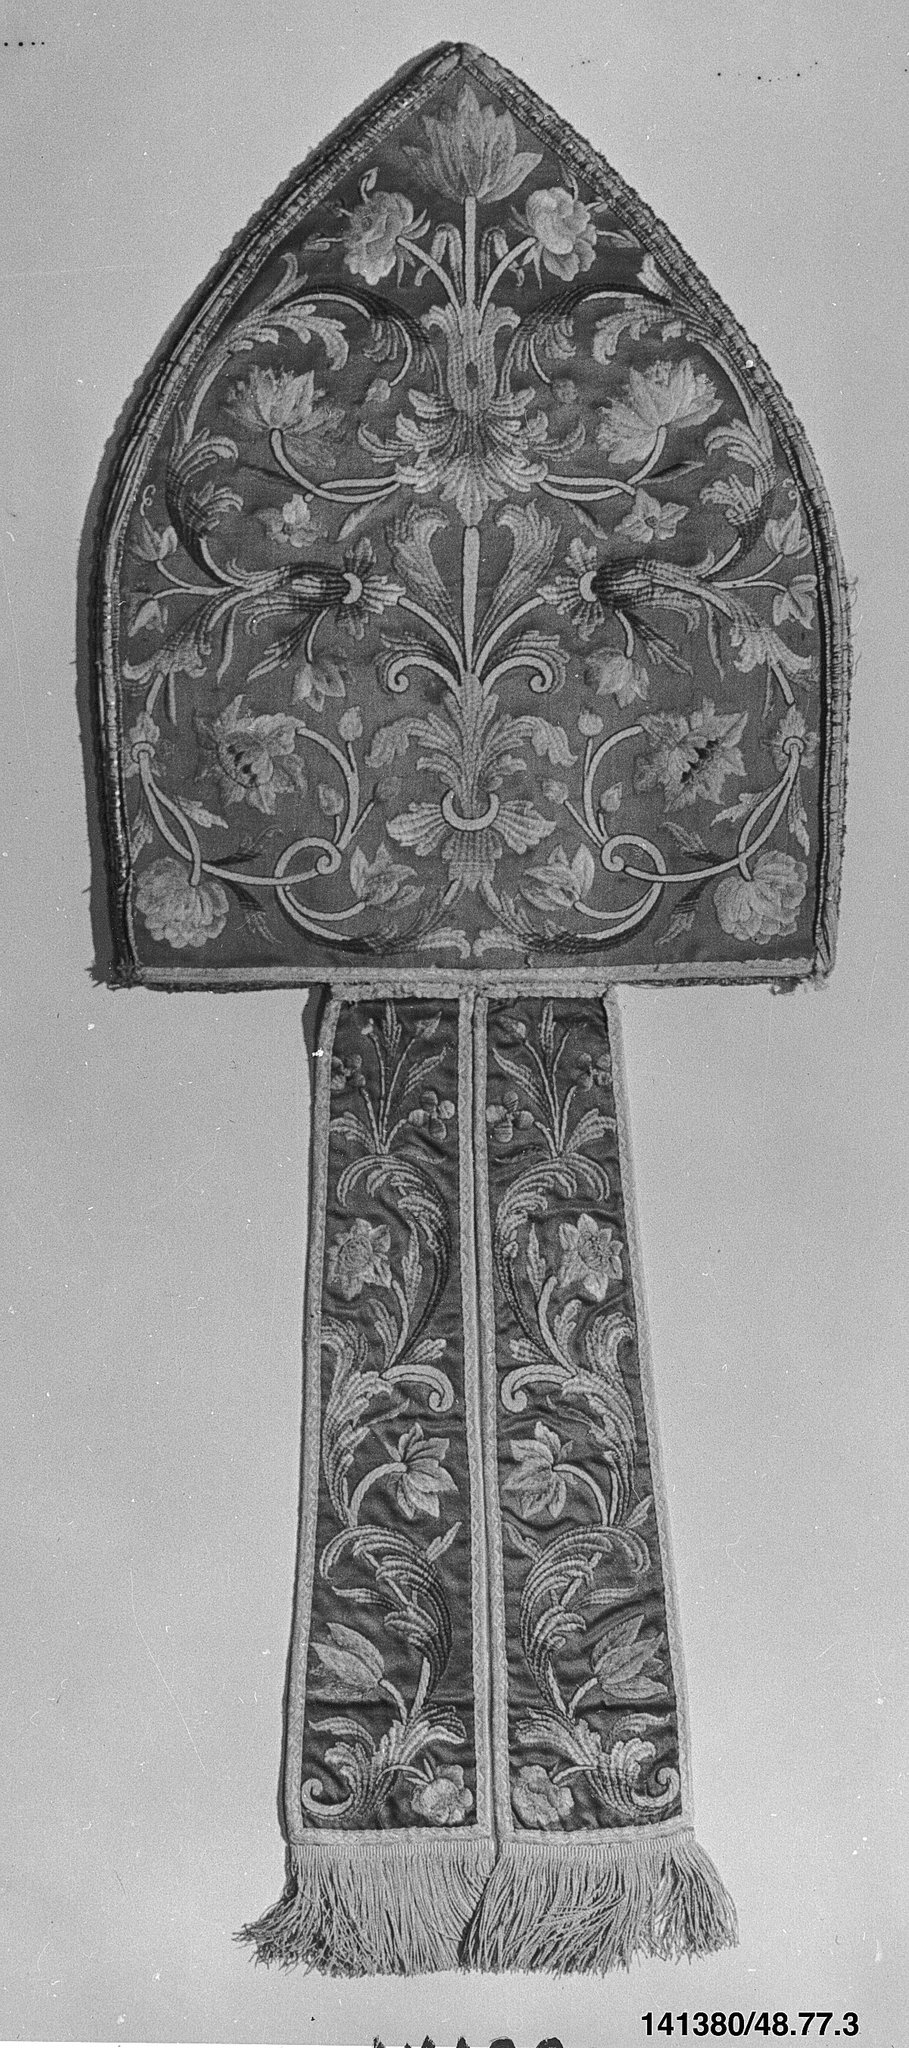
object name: mitre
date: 1830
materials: metal thread, silk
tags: flowers